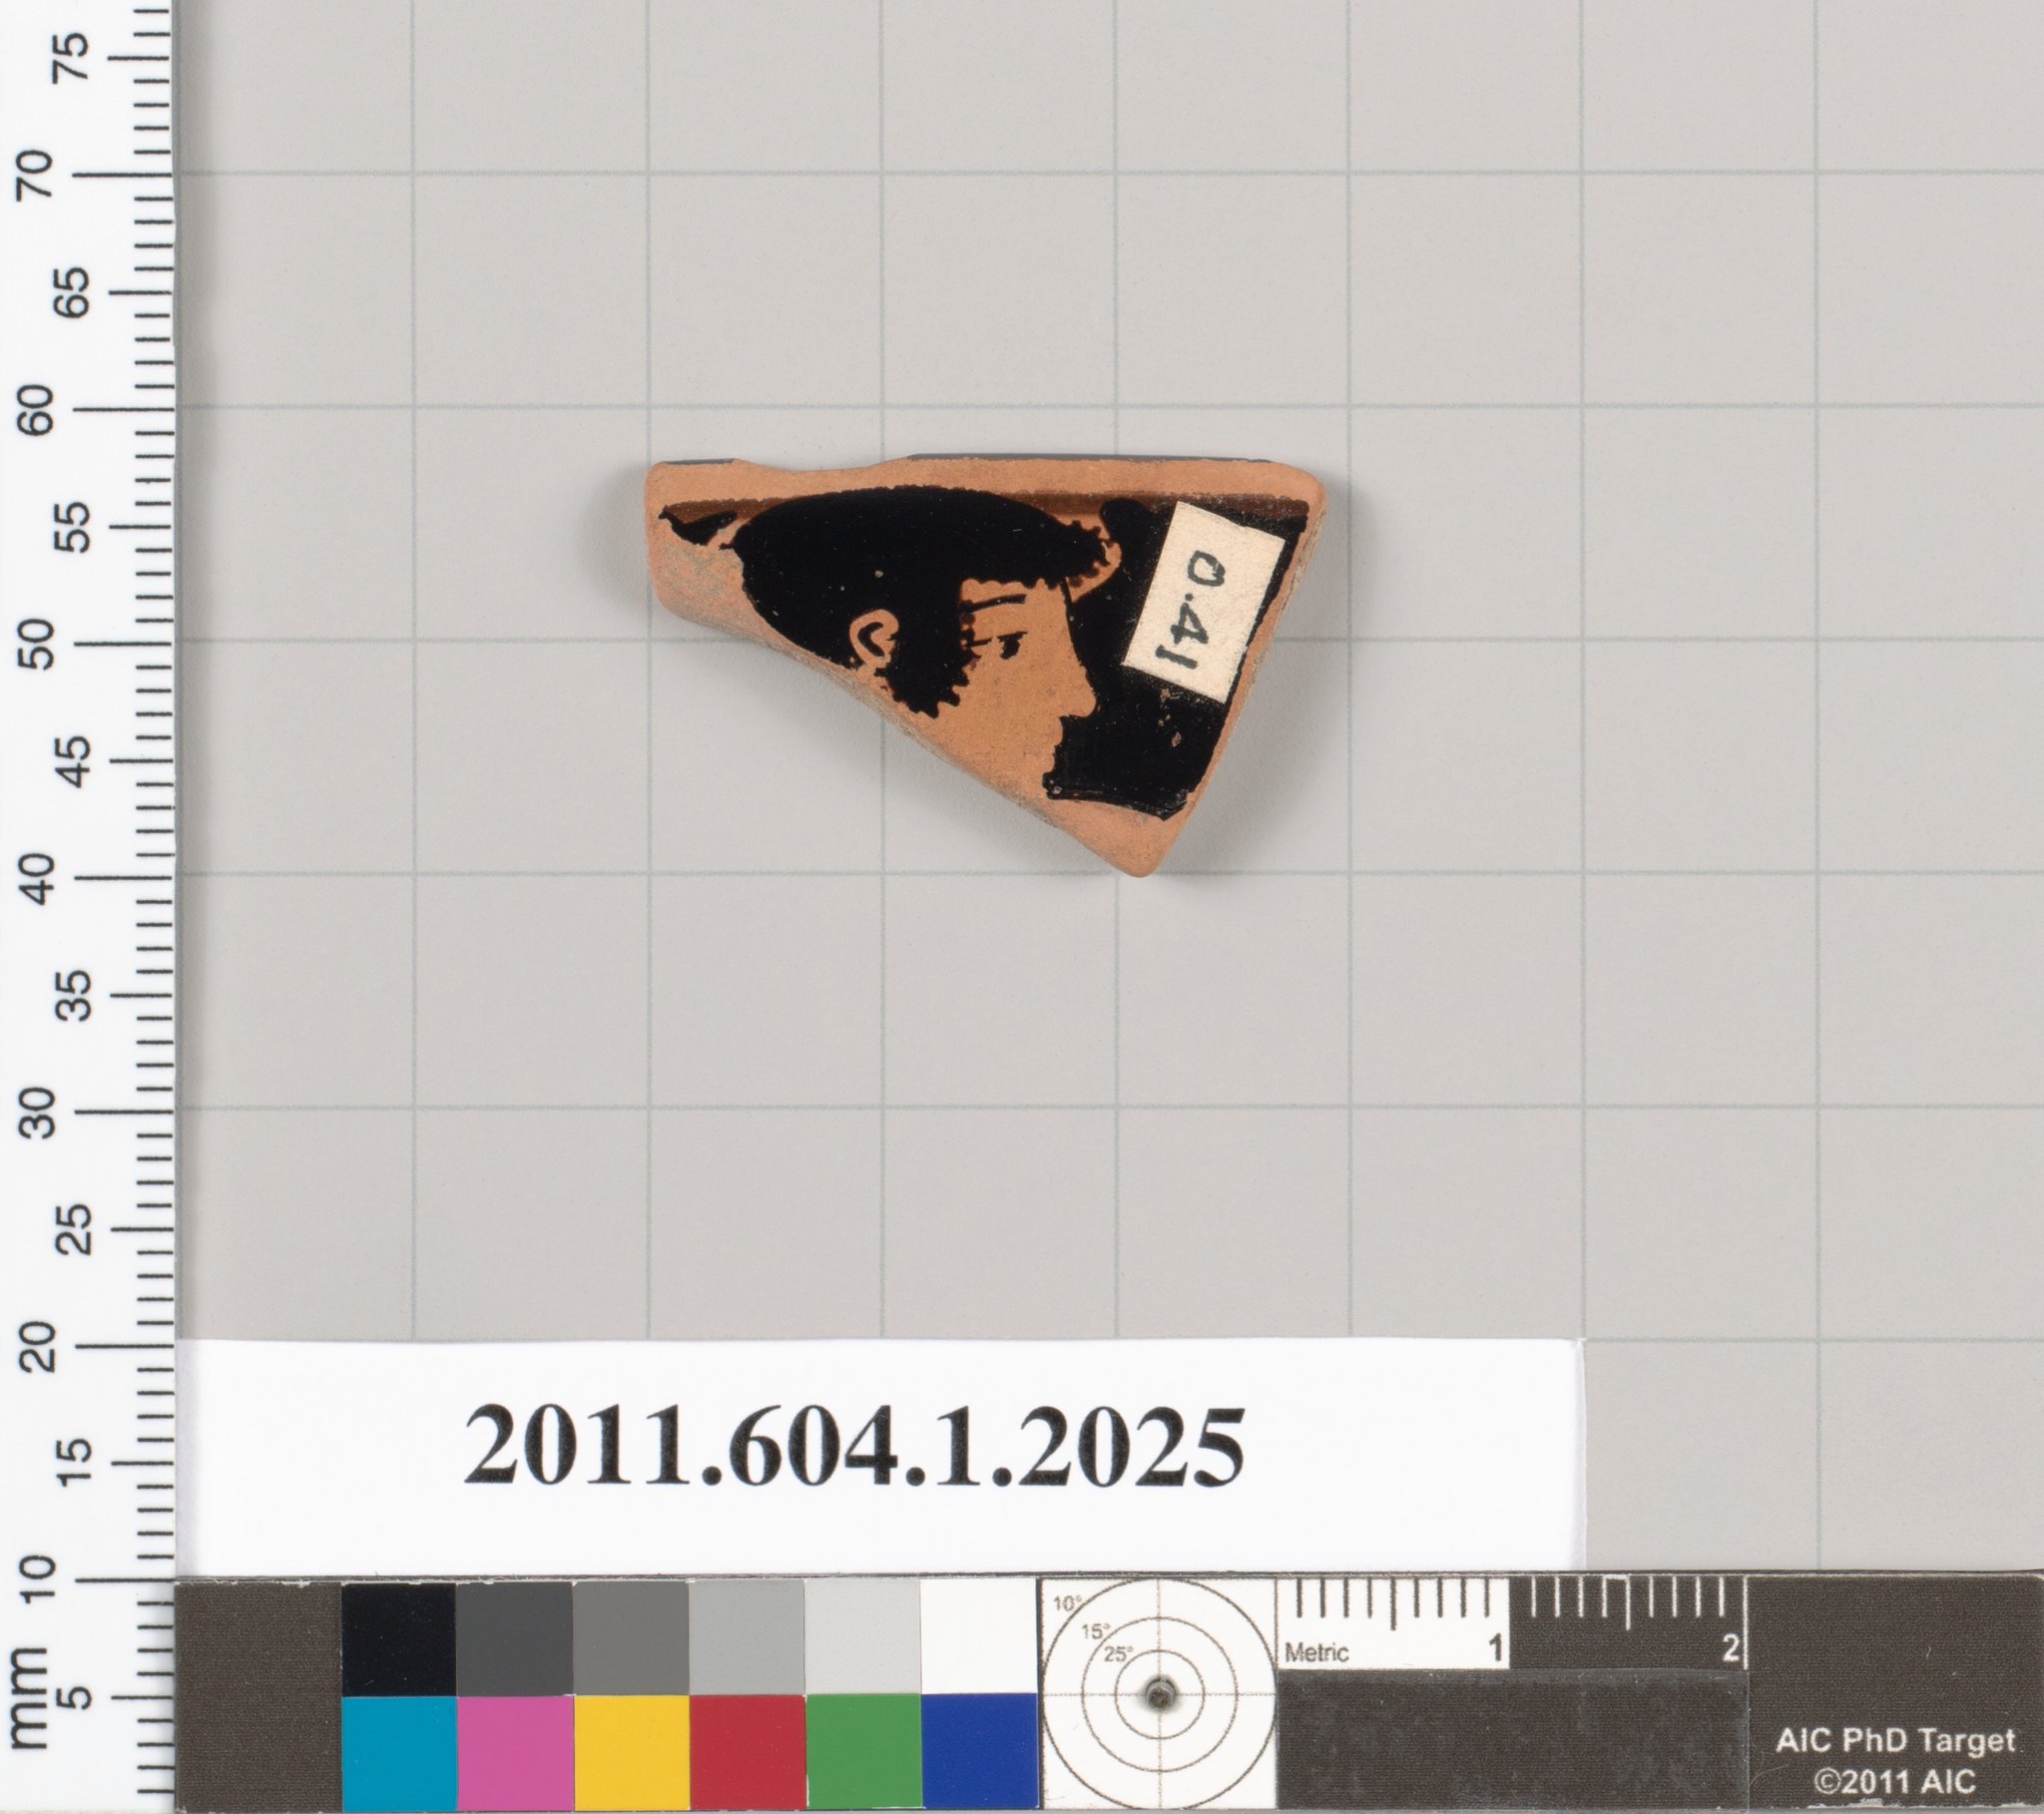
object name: kylix fragment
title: Terracotta rim fragment of a kylix (drinking cup)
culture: greek, attic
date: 500-468 BCE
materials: terracotta